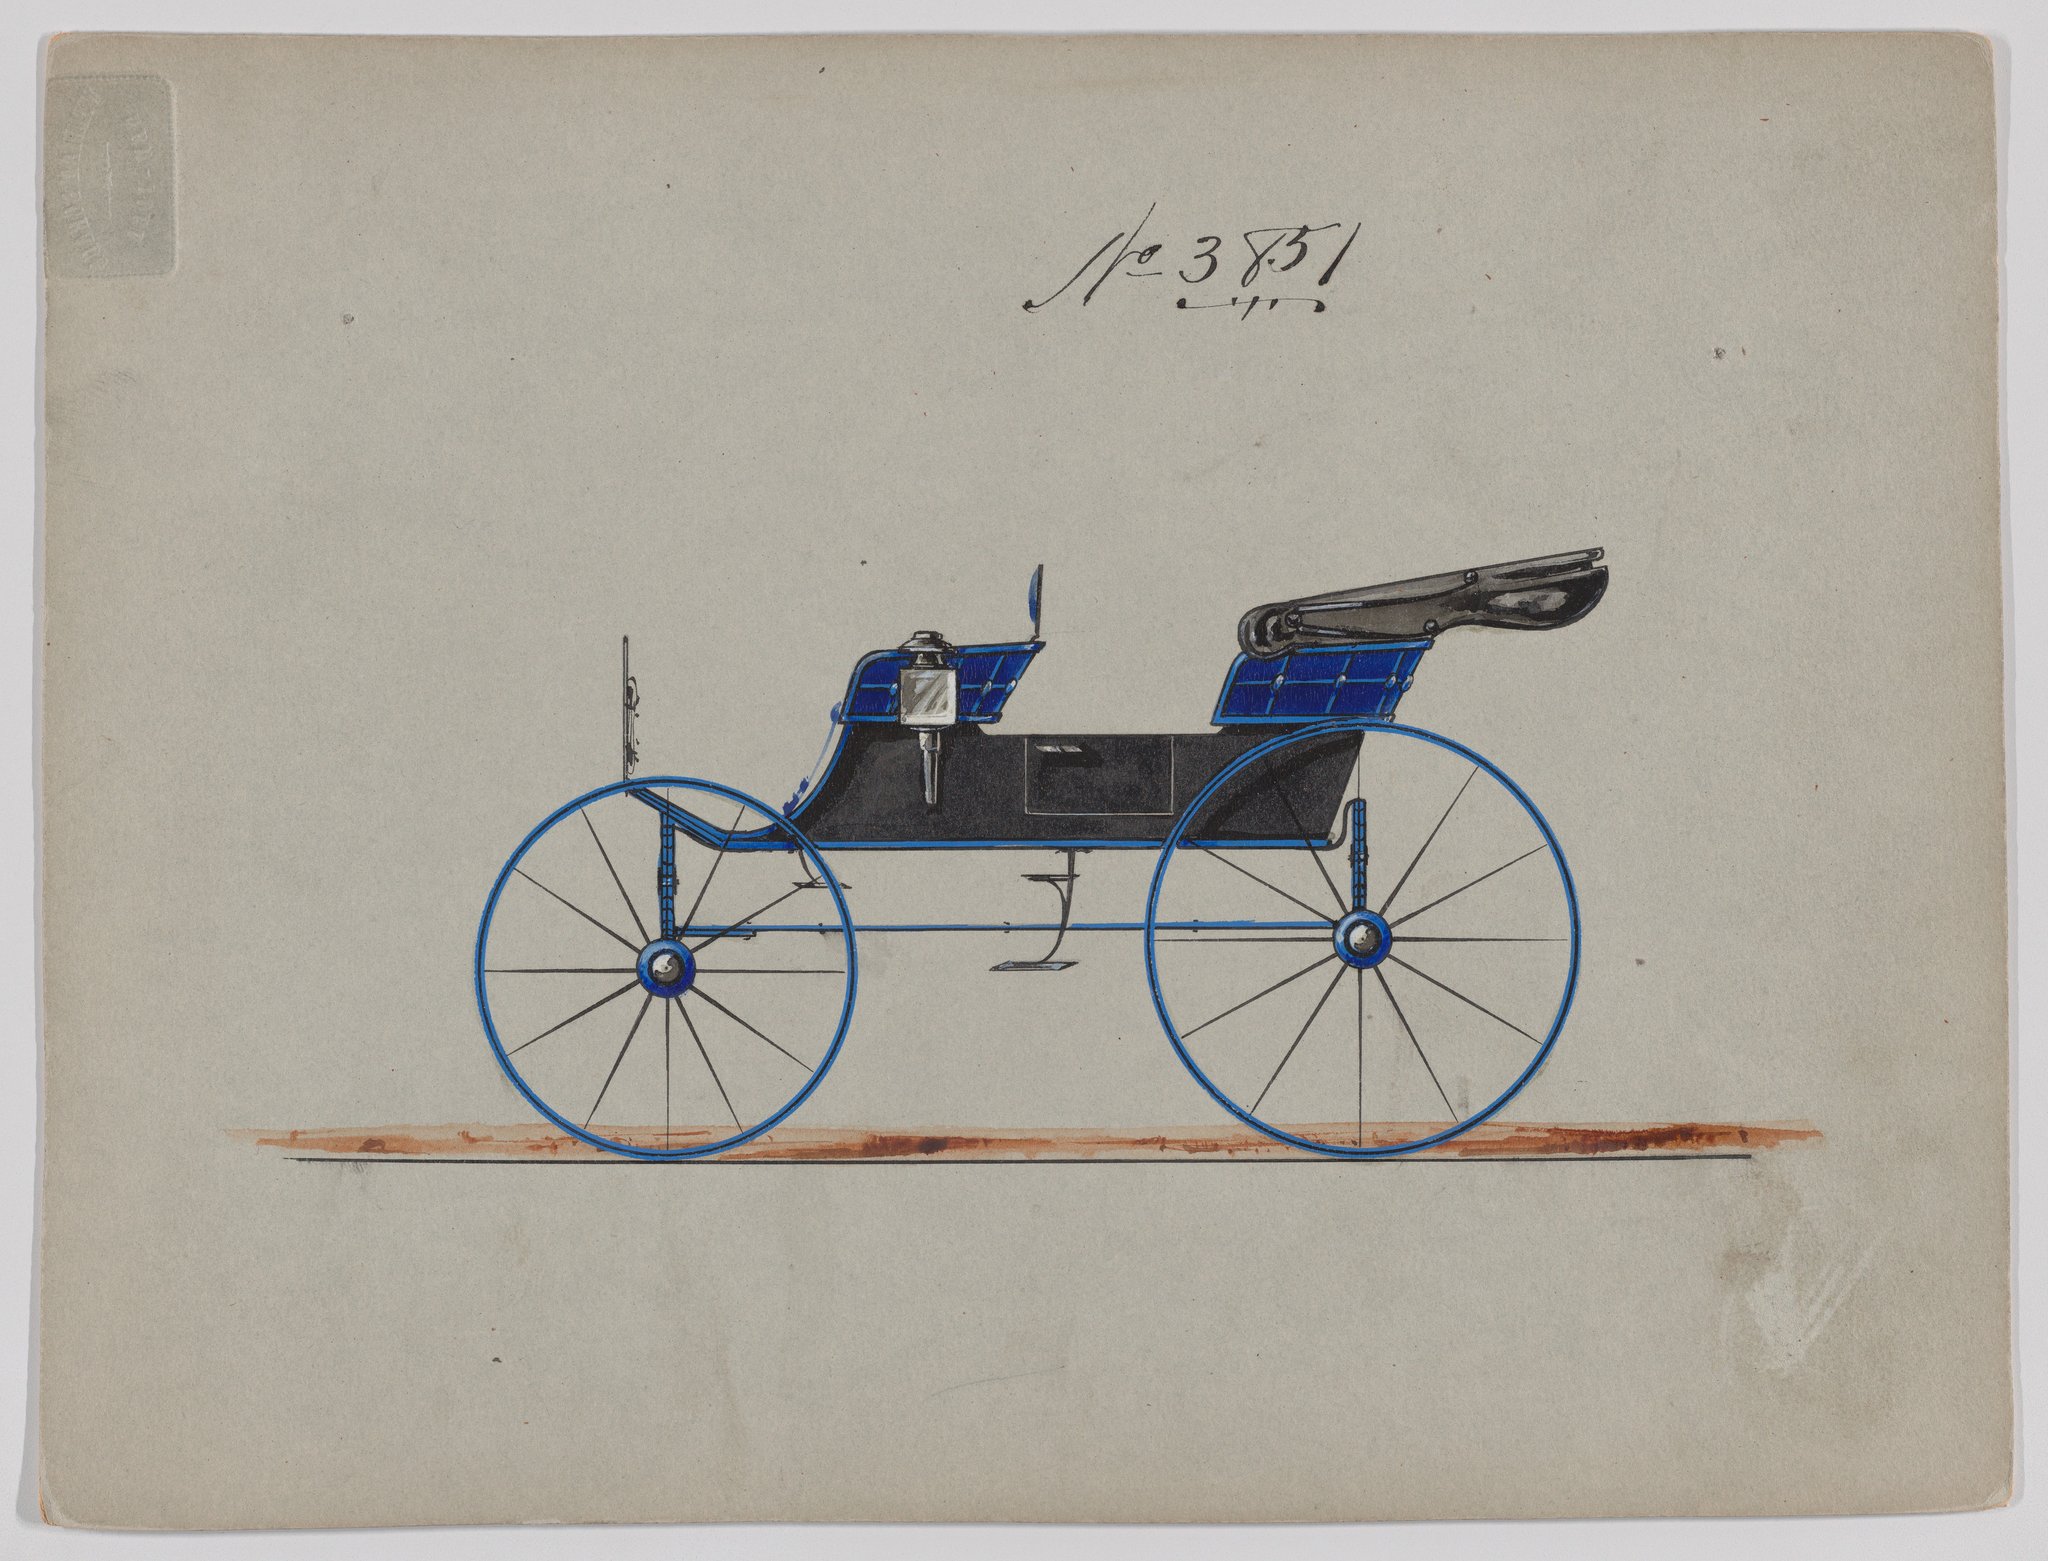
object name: drawing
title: Design for 2 seat Phaeton, no. 3851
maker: brewster & co.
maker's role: manufacturer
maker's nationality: american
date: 1883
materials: gouache, gum arabic, ink, watercolor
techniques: pen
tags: carriages